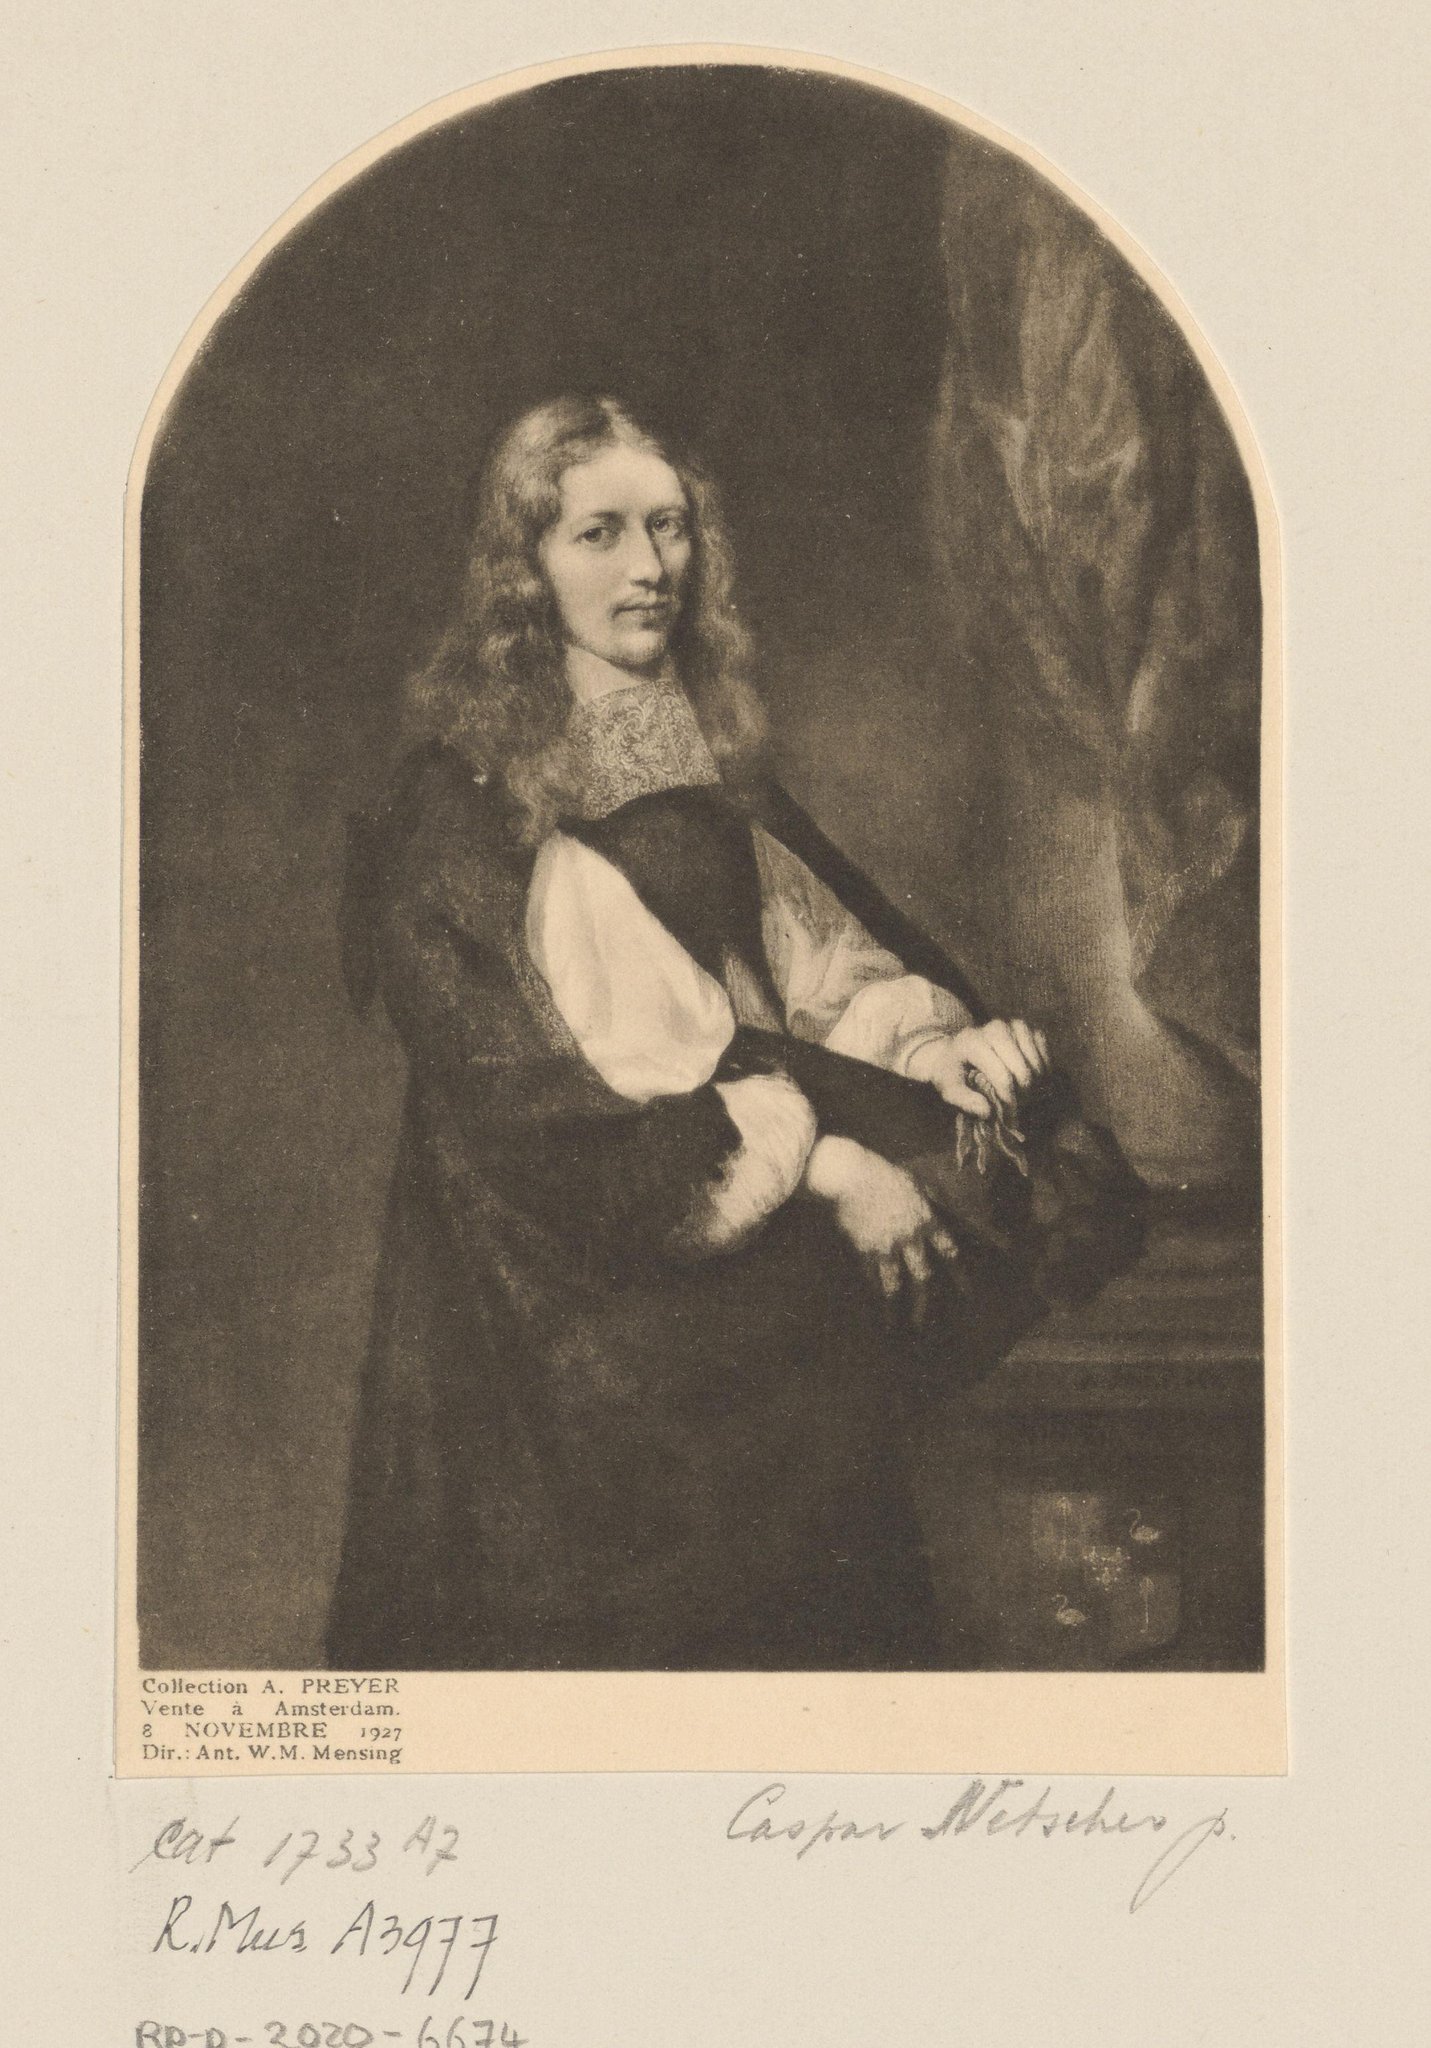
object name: photomechanical print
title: Portret van Pieter de Graeff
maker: Anonymous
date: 1927-1950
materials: paper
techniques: photograph, letterpress printing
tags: politician, historical persons, politician, e.g. party leader